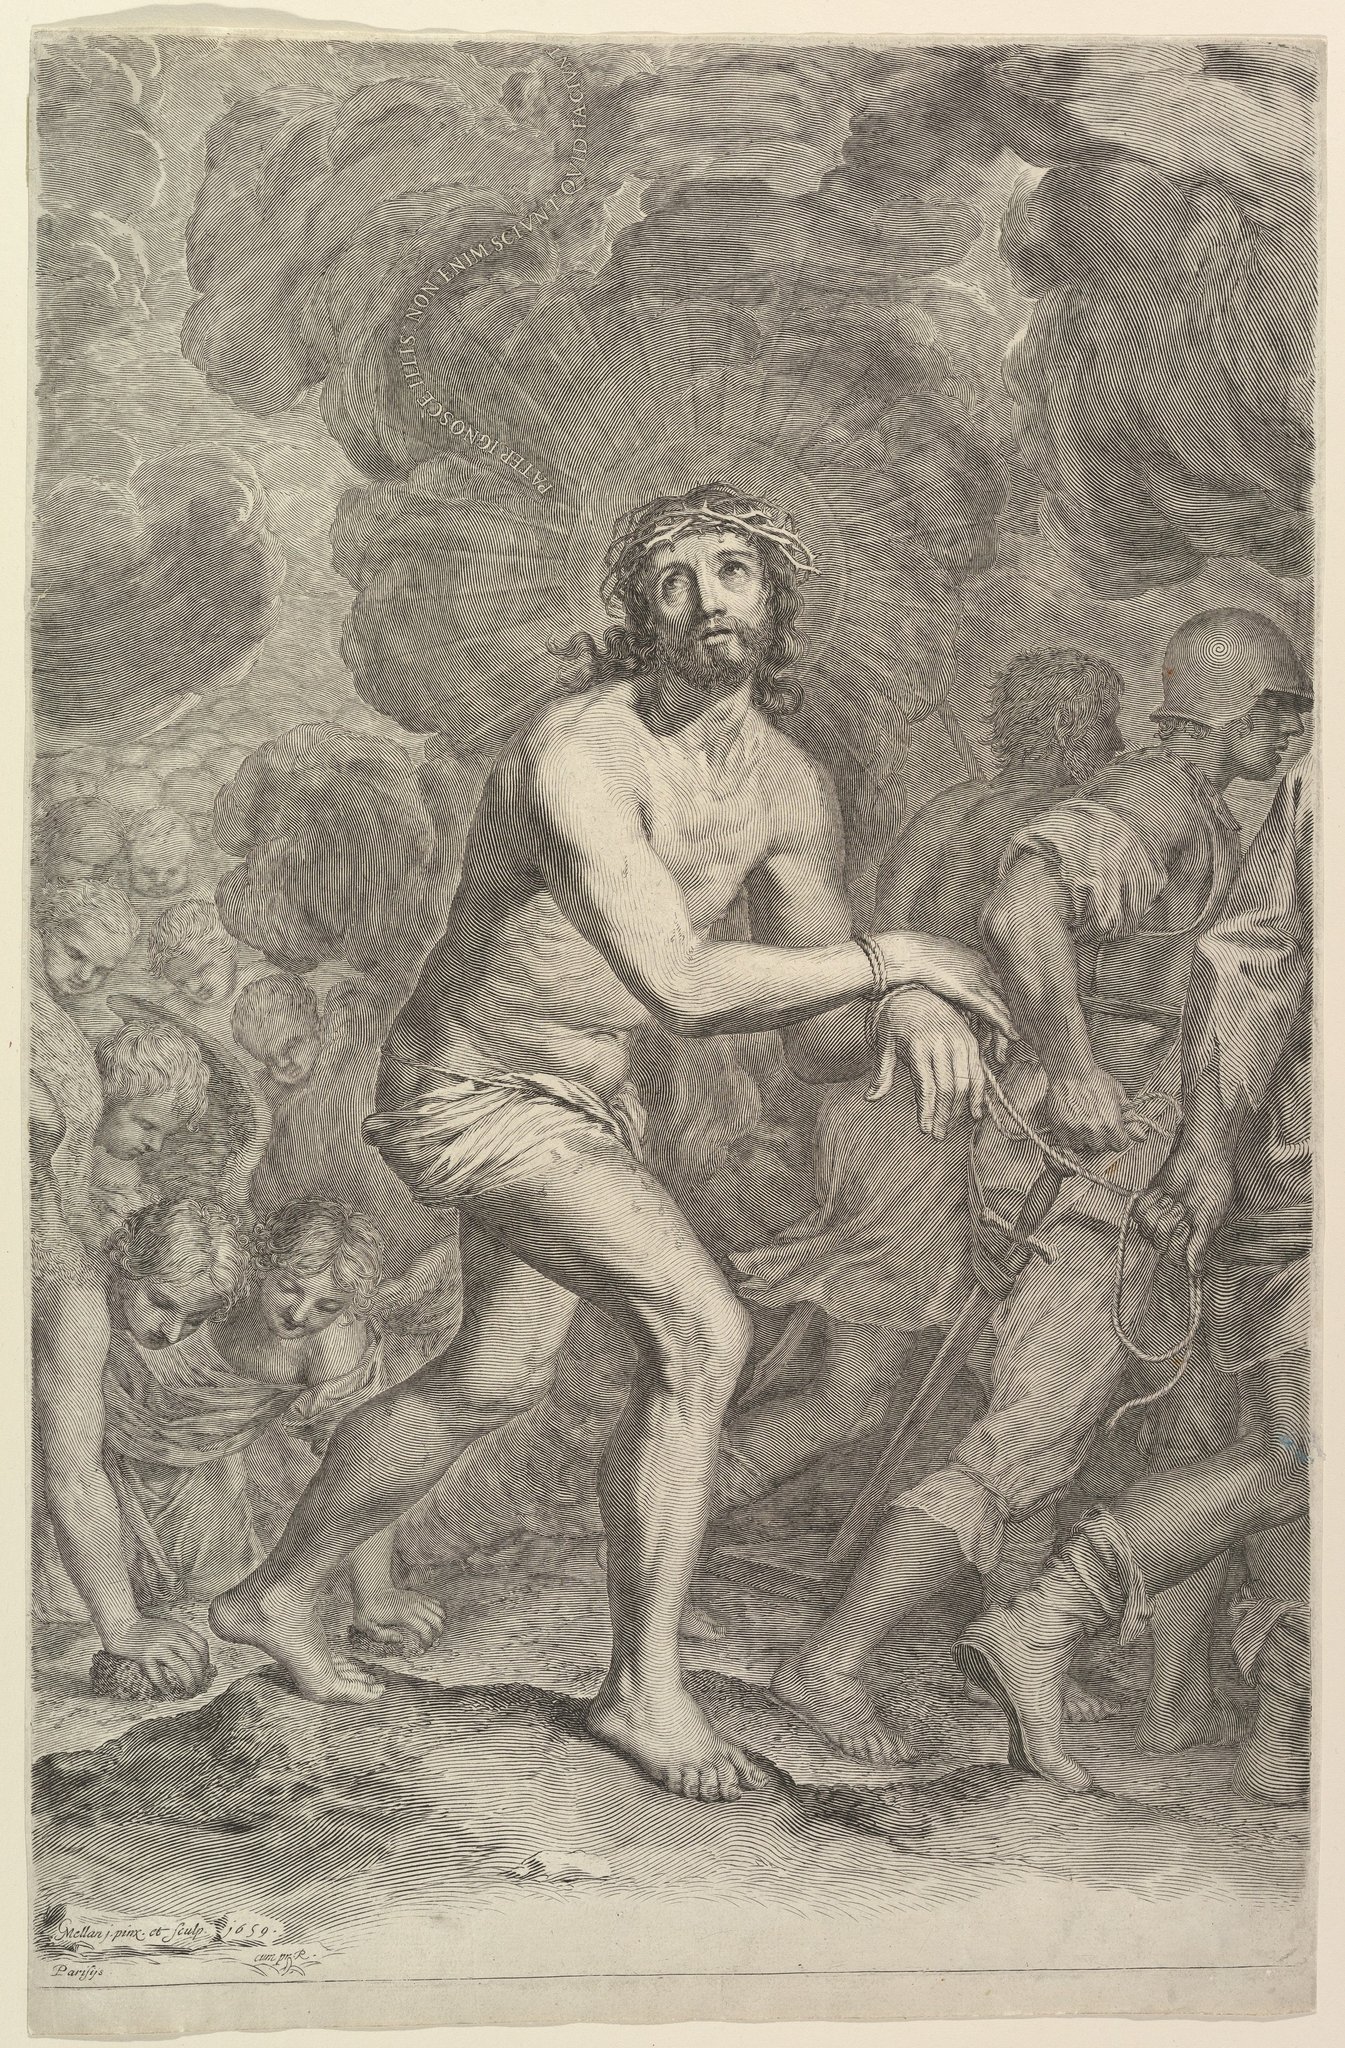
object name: print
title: Christ Taken by Soldiers (La Montée au Calvaire)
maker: claude mellan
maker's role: artist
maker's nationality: french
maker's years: 1598-1688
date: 1659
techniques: engraving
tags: soldiers,angels,christ